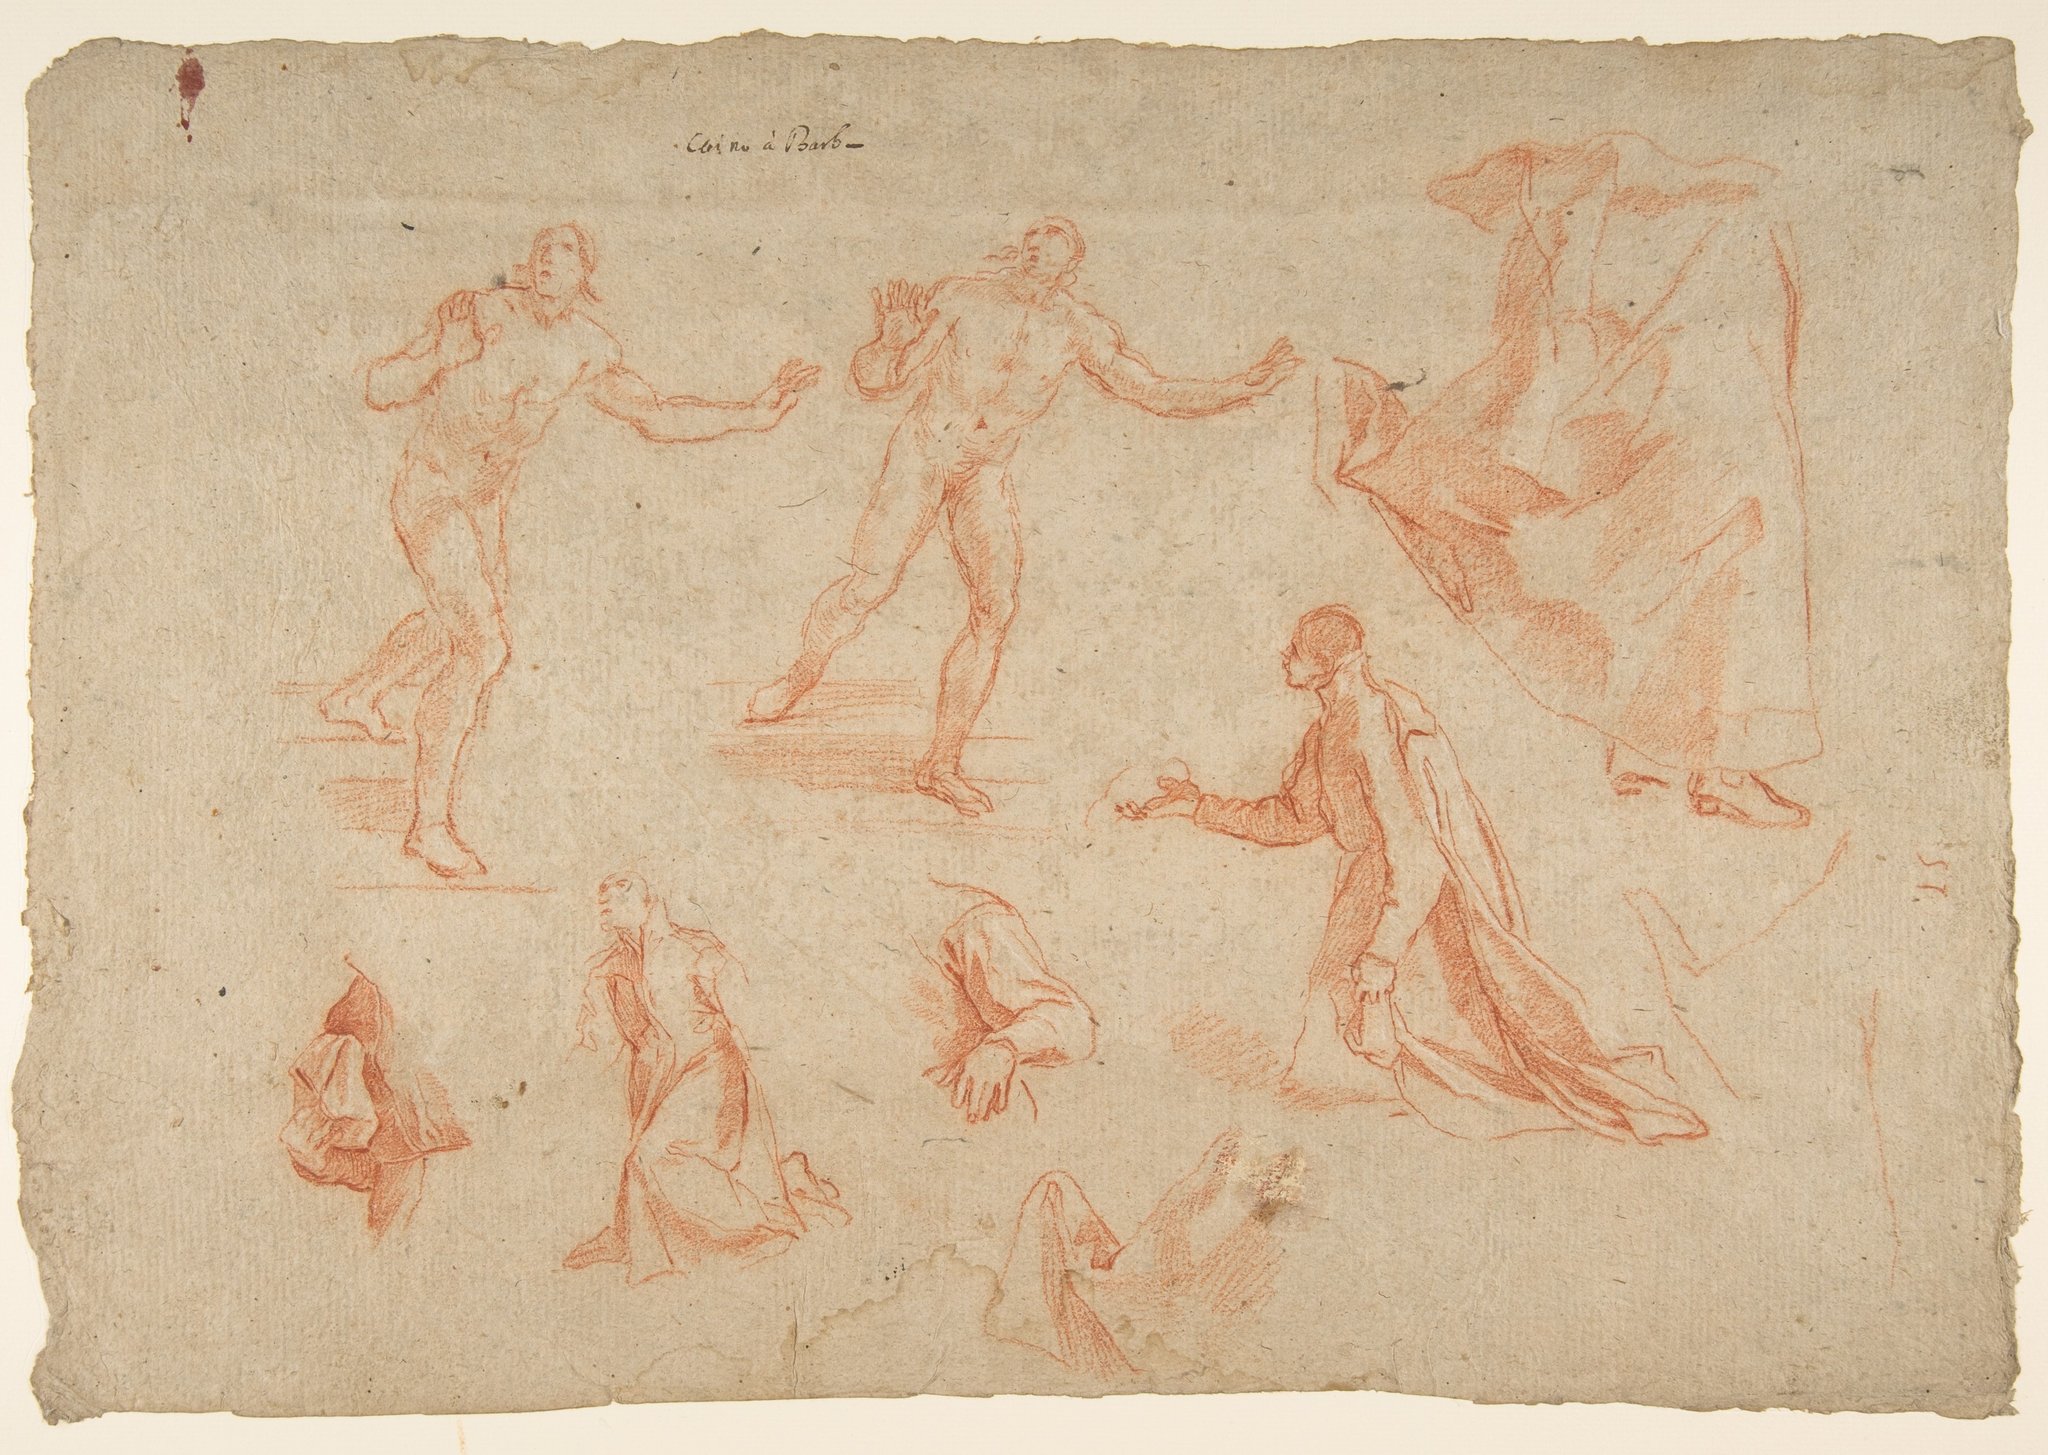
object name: drawing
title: Figure and Drapery studies (recto); Three Studies of a Male Torso for the "Coronation of Marcantonio Pasqualini'" (verso)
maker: andrea sacchi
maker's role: artist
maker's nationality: italian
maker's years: 1599-1661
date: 1641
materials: chalk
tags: hands,male nudes